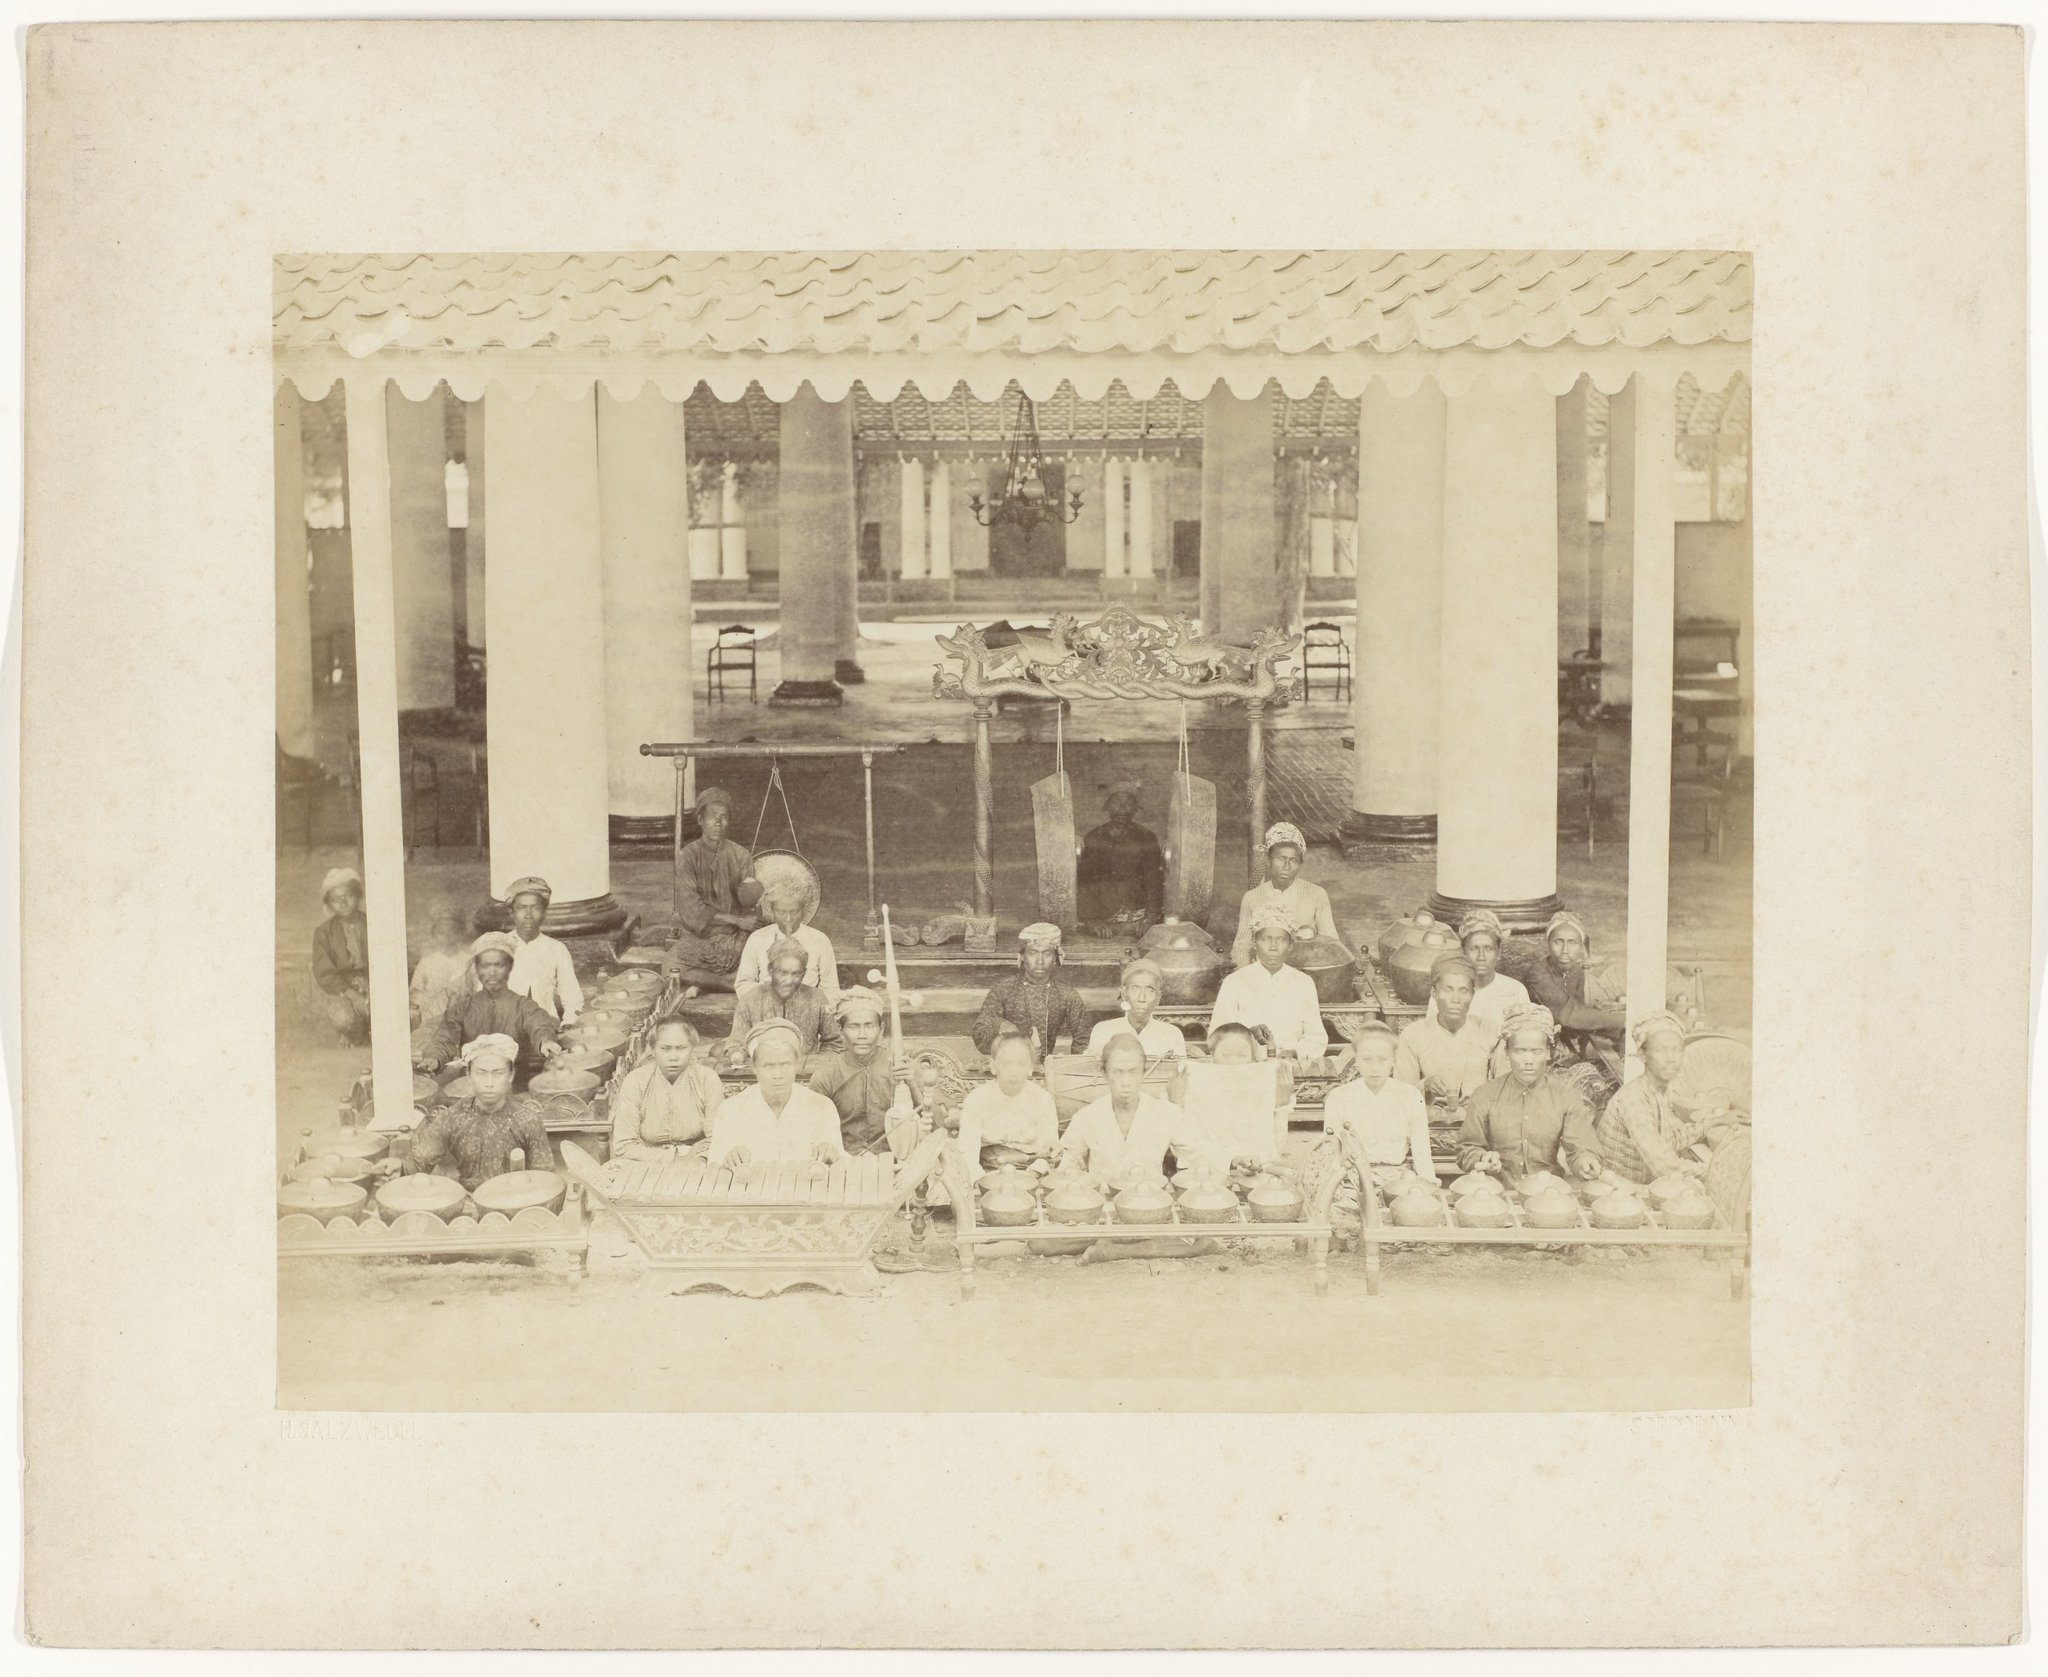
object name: photograph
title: Gamelanorkest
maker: herman salzwedel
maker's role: fotograaf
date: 1880-1888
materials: photographic support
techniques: albumen print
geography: surabaya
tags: java, surabaya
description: Een gamelanorkest, waarschijnlijk te Soerabaja. Onderdeel van een groep van 62 foto's in een doos met het opschrift "Staatsspoorwegen op Java" uit 1888.